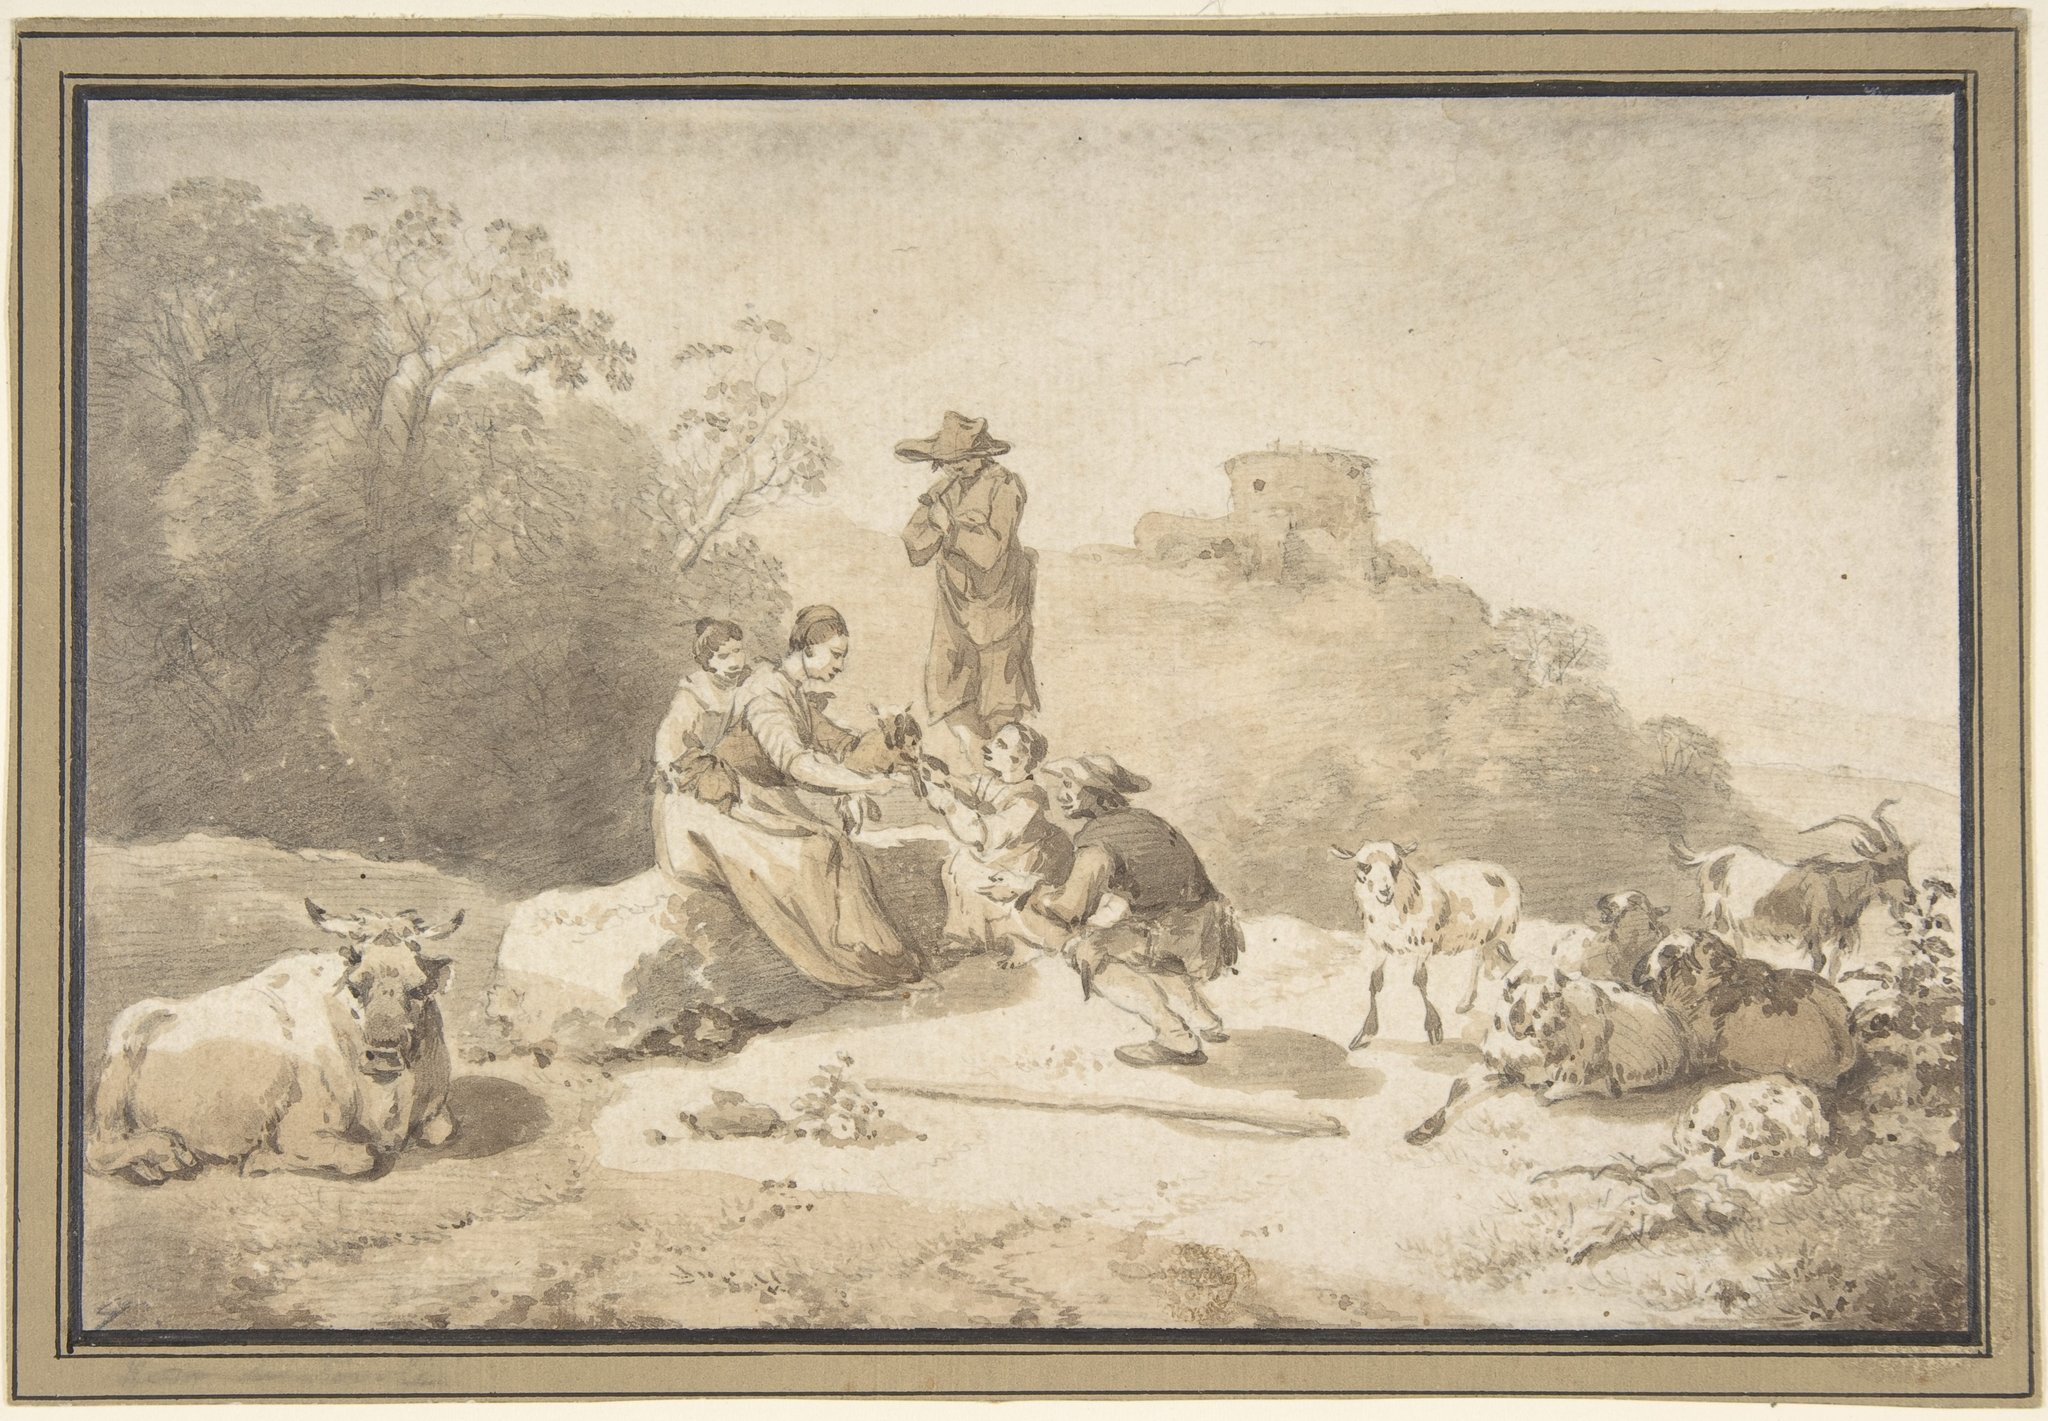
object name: drawing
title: Pastoral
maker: willem romeyn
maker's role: artist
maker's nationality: dutch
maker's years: 1624-1694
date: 1640-1694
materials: chalk, ink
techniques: brush, wash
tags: men,women,cows,goats,pastoral